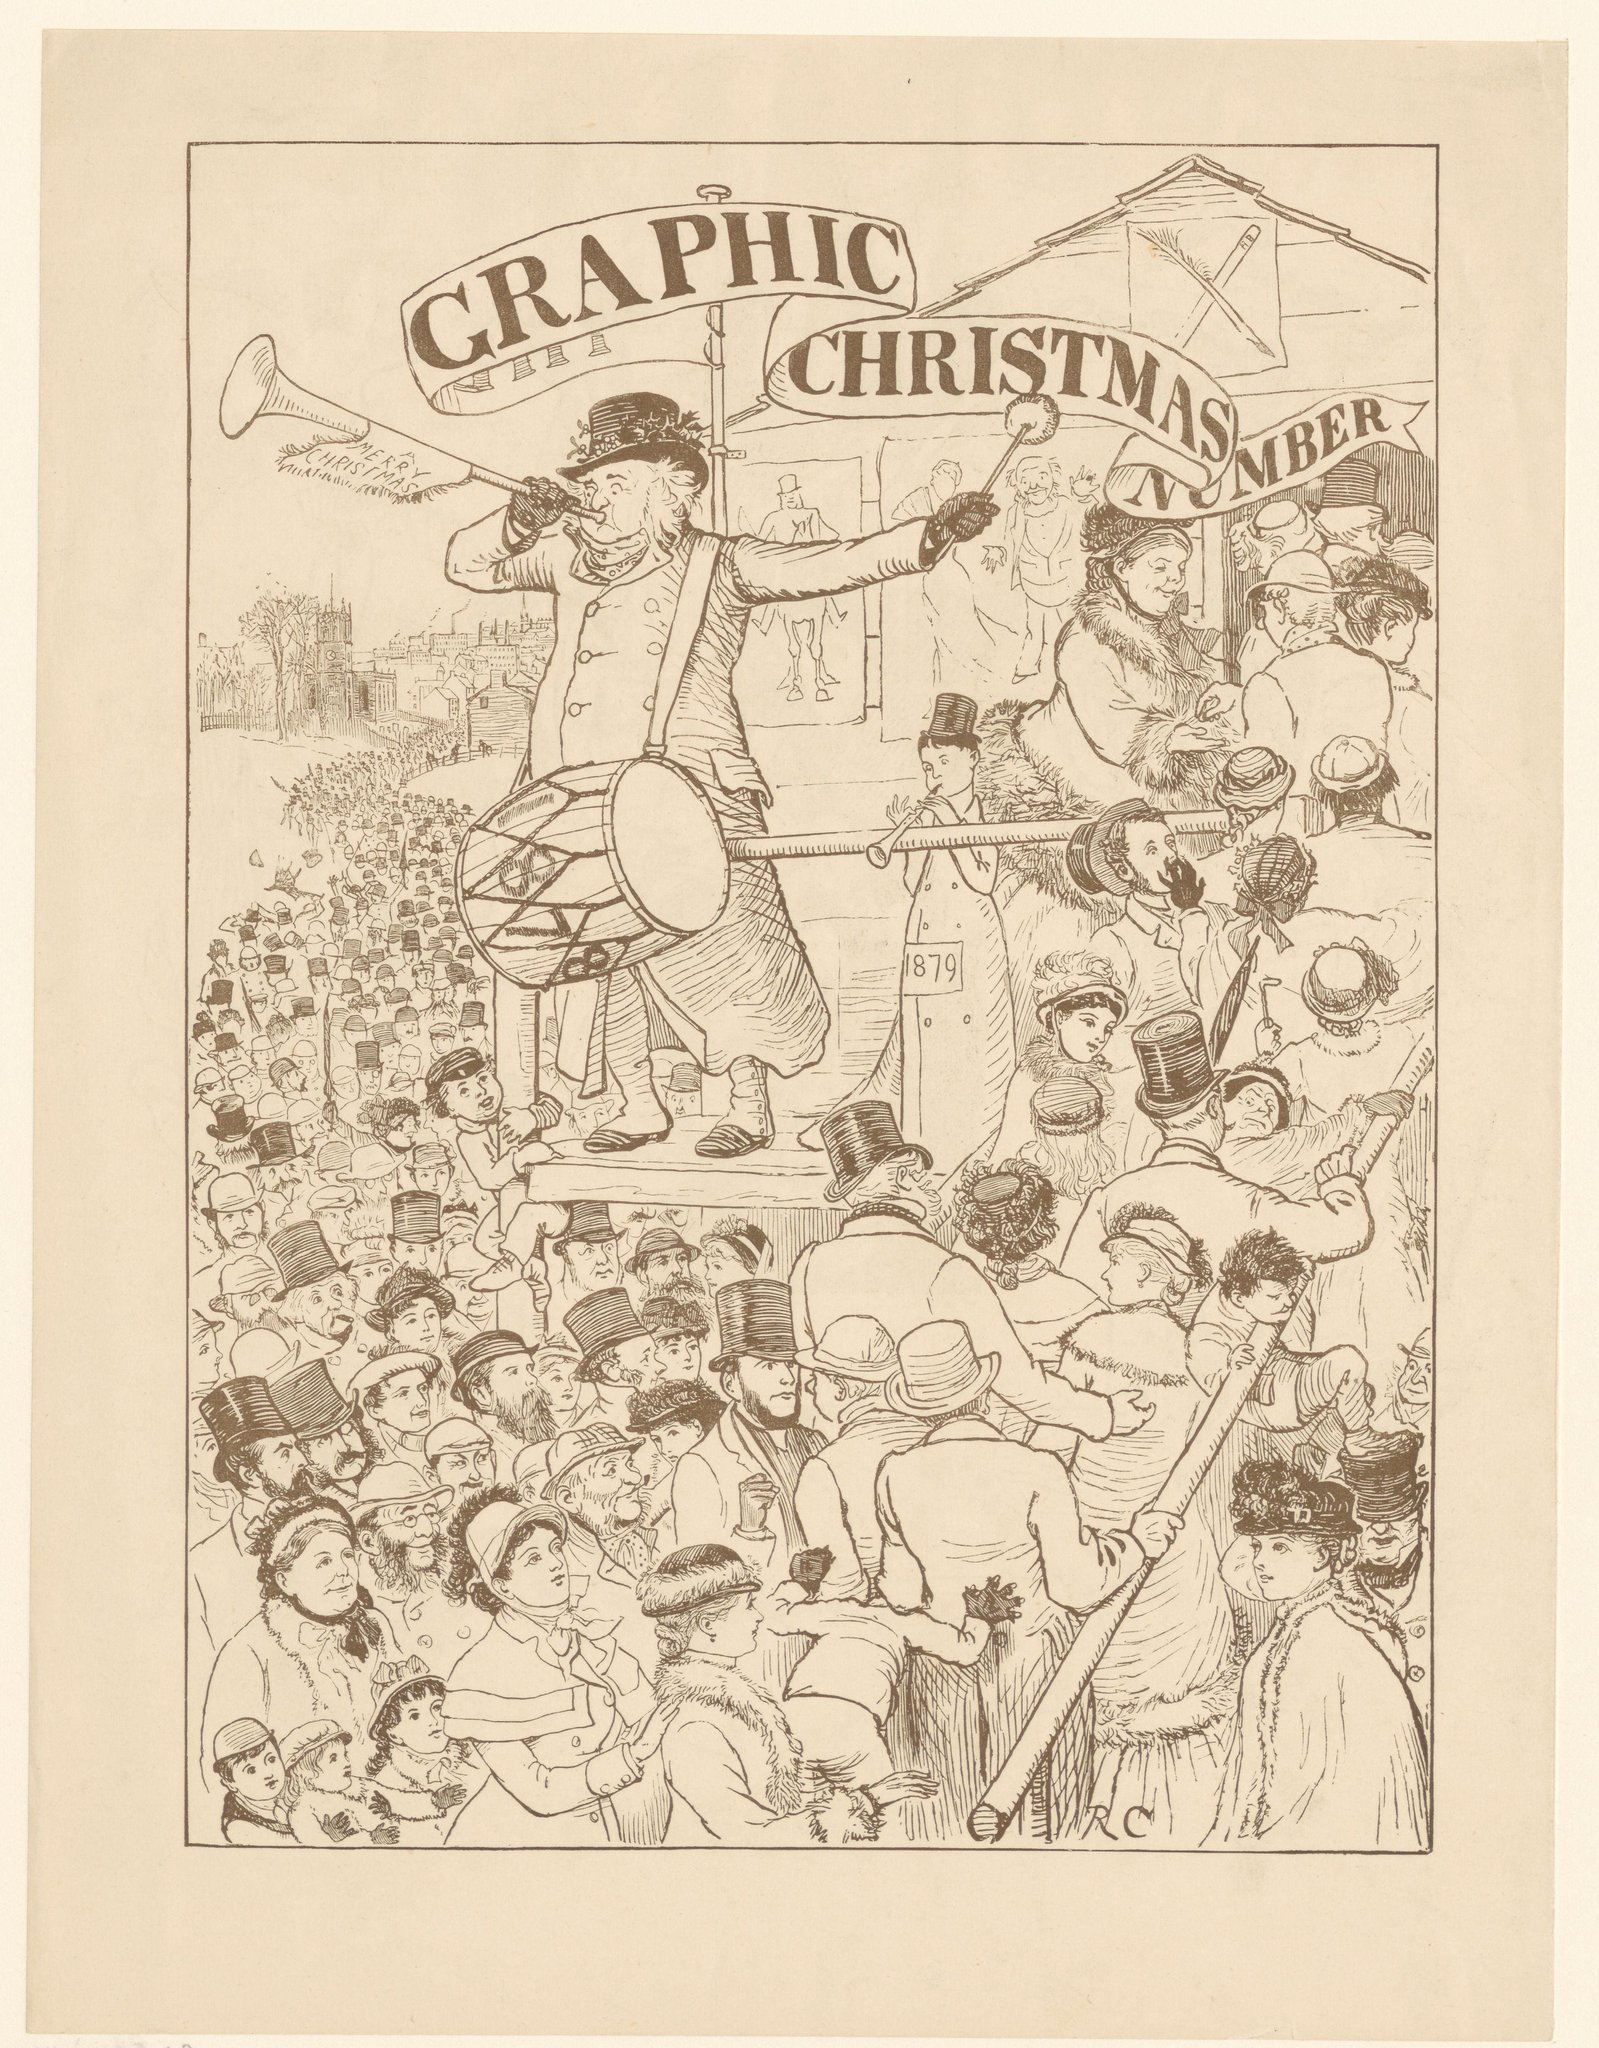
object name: print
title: Lange rij met mensen loopt langs een verhoging met muzikanten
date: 1878-1880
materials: paper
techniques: engraving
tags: crowd, mob, horn, trumpet, cornet, trombone, tuba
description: Ontwerp voor de kerstuitgave van de periodiek 'The Graphic' in 1878.